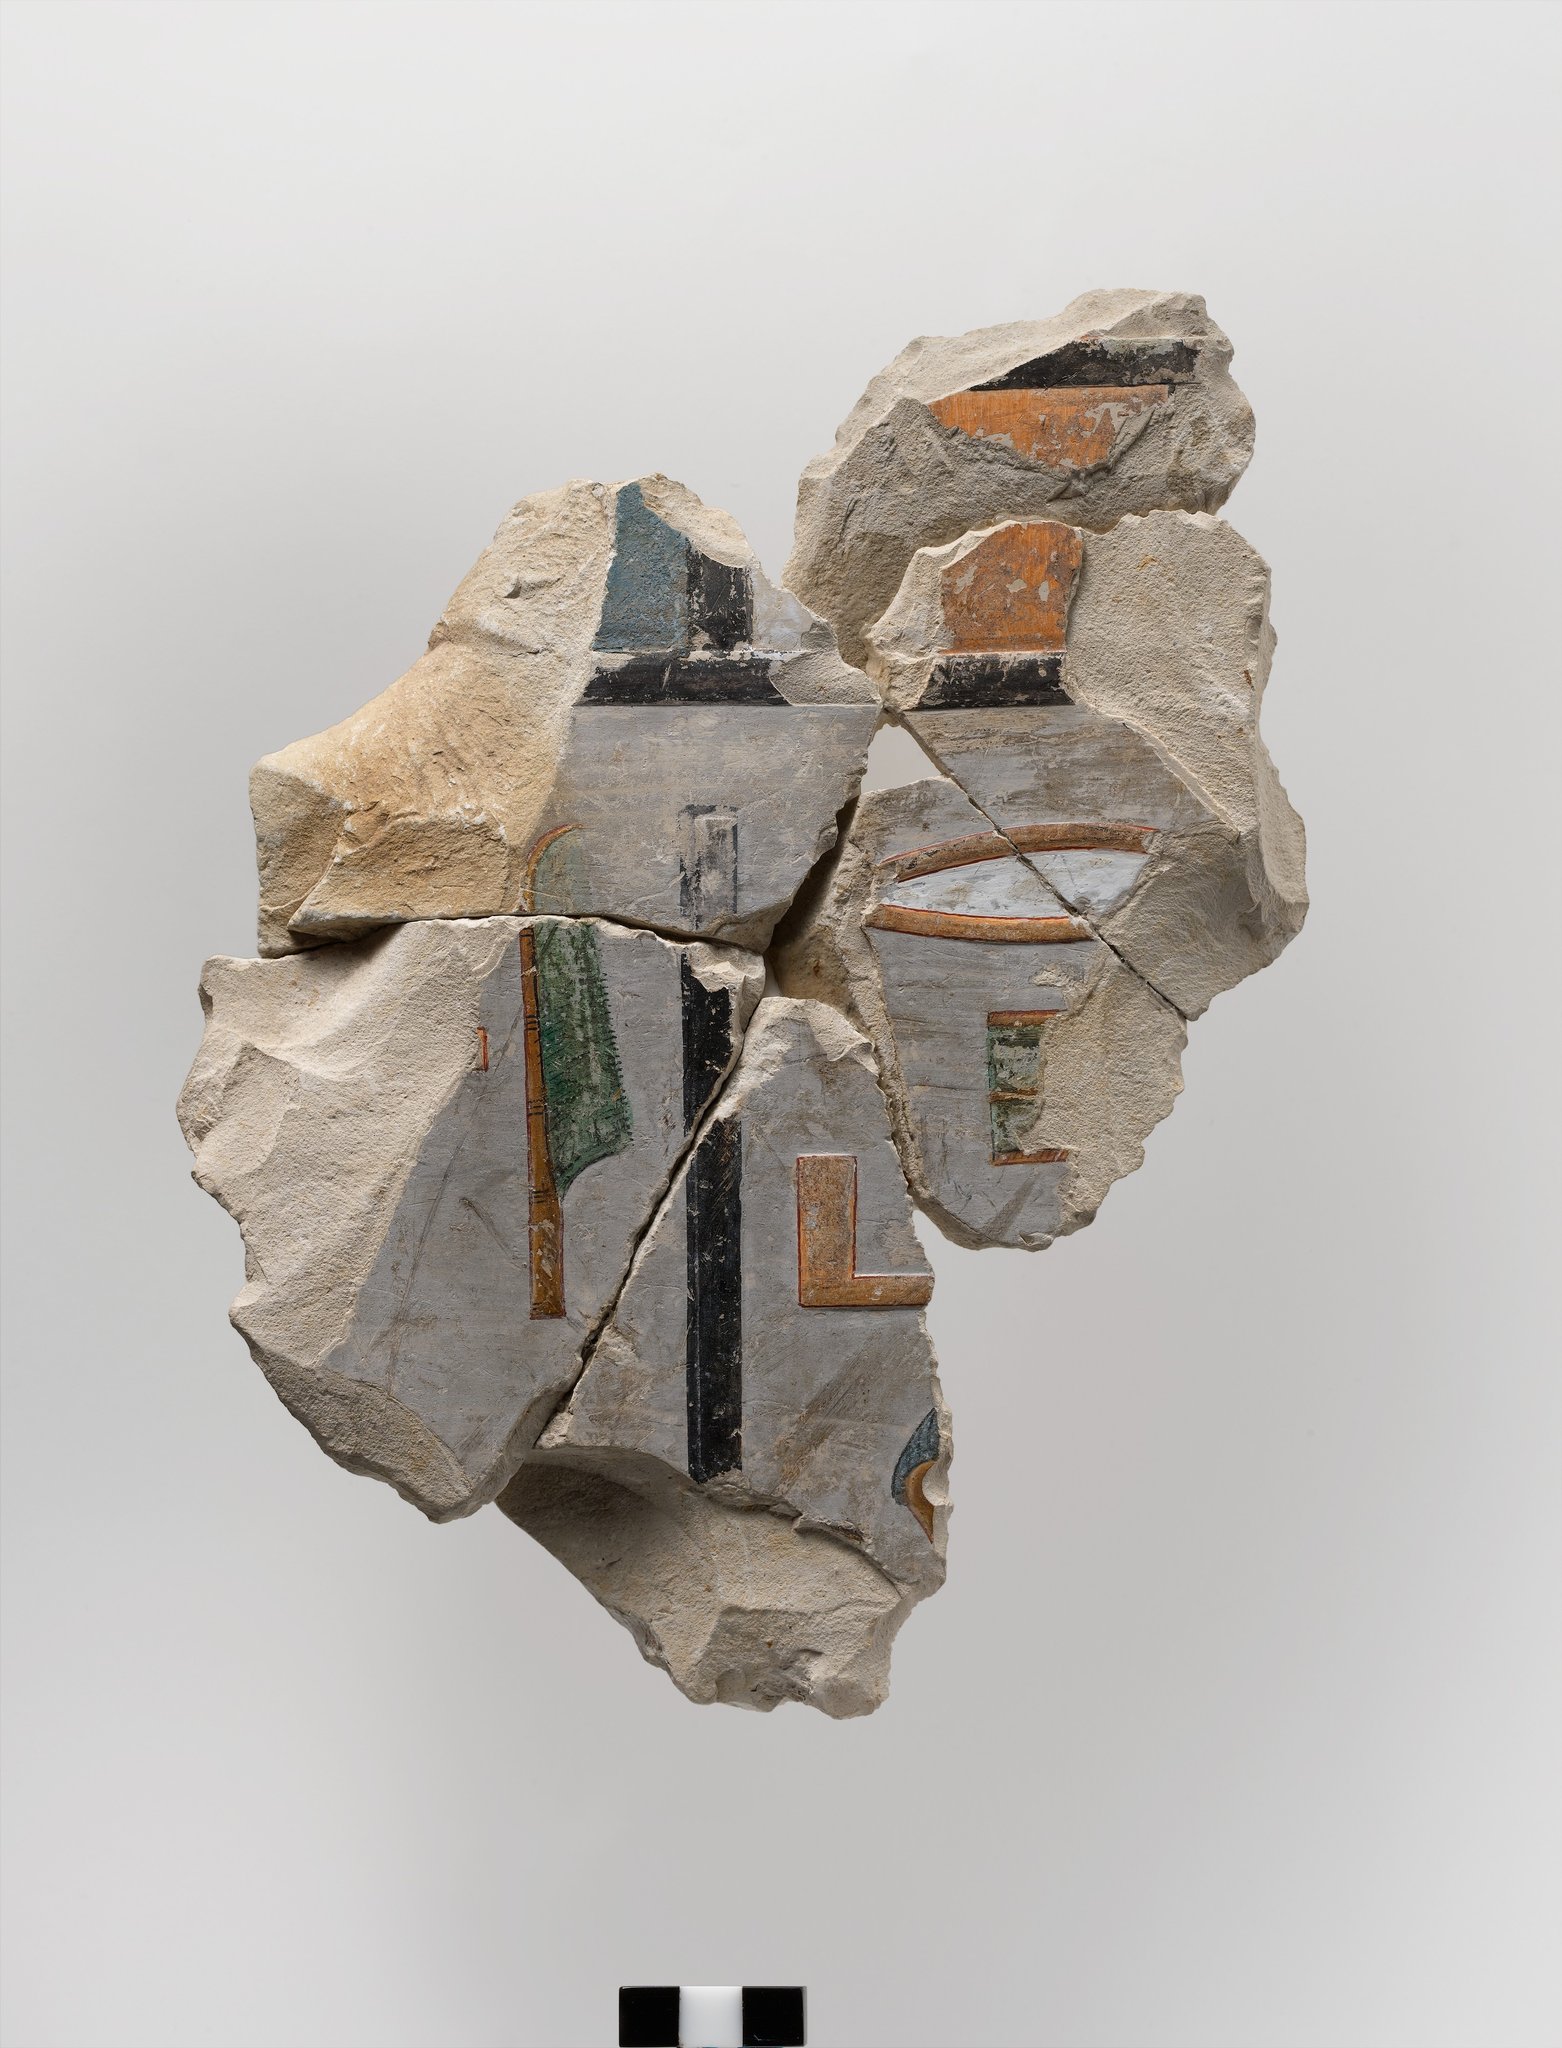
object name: relief fragment, tomb of meketre, hieroglyph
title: Relief fragment, tomb of Meketre, hieroglyphs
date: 1981-1975 BCE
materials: limestone, paint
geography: egypt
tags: hieroglyphs